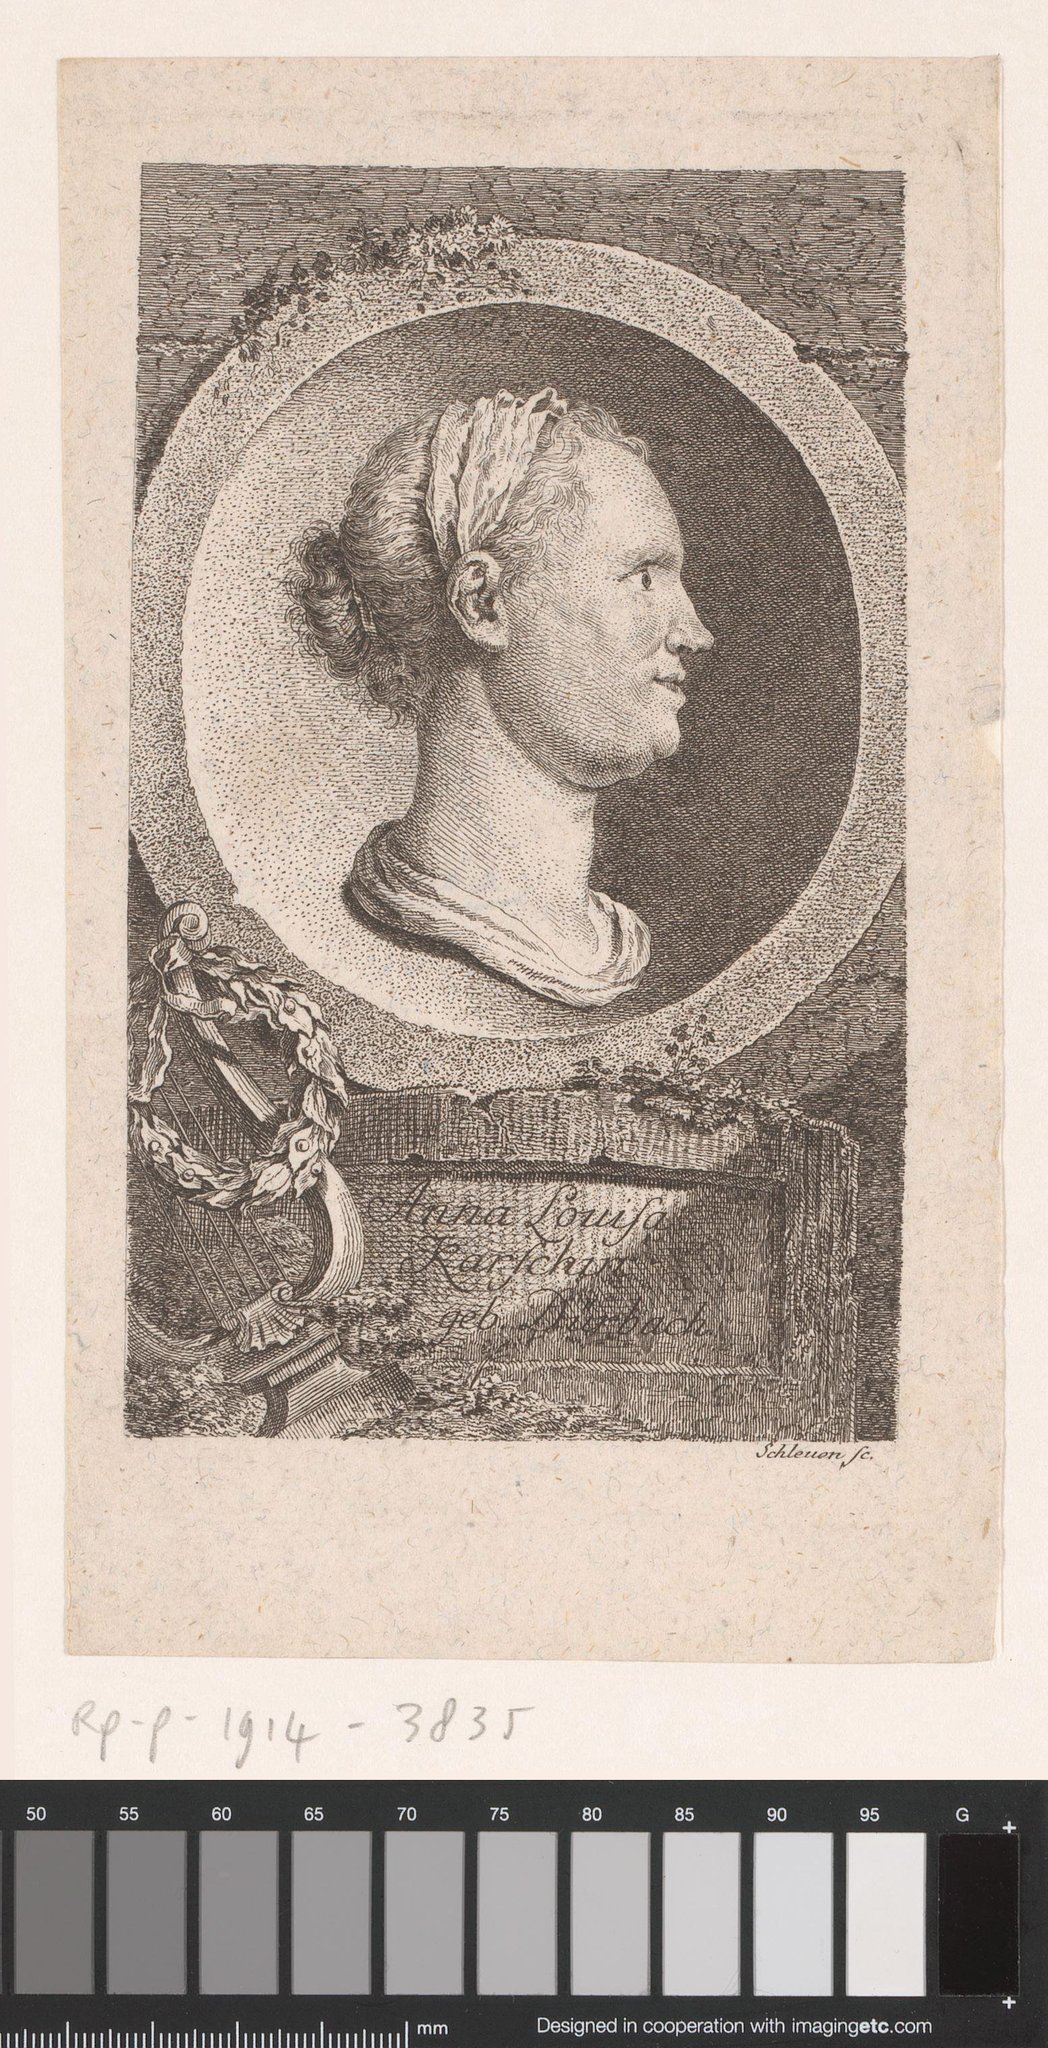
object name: print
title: Portret van Anna Luise Karsch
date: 1721-1771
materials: paper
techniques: etching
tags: berlin, lyre, cithara, psaltery, historical persons - bb - woman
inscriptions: collector's mark: Lugt 2228